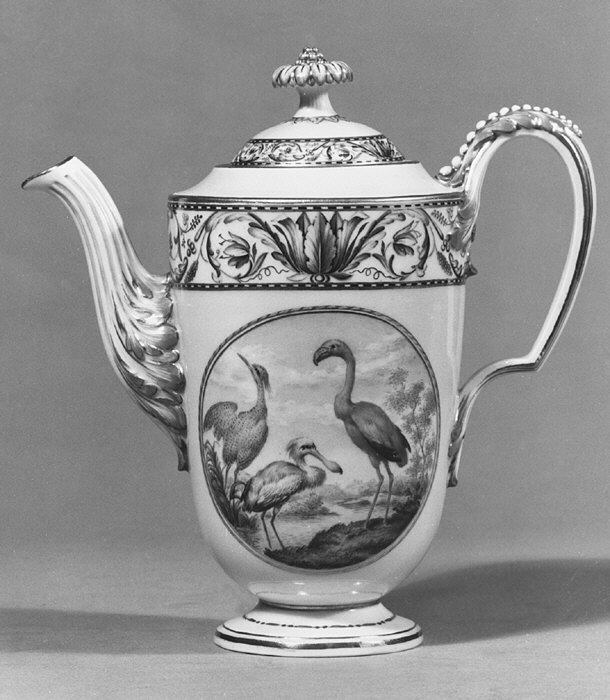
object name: coffeepot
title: Coffeepot (part of a service)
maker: meissen manufactory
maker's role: manufactory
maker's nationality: german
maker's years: 1710-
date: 1780-1785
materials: hard paste porcelain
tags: birds,flowers,trees